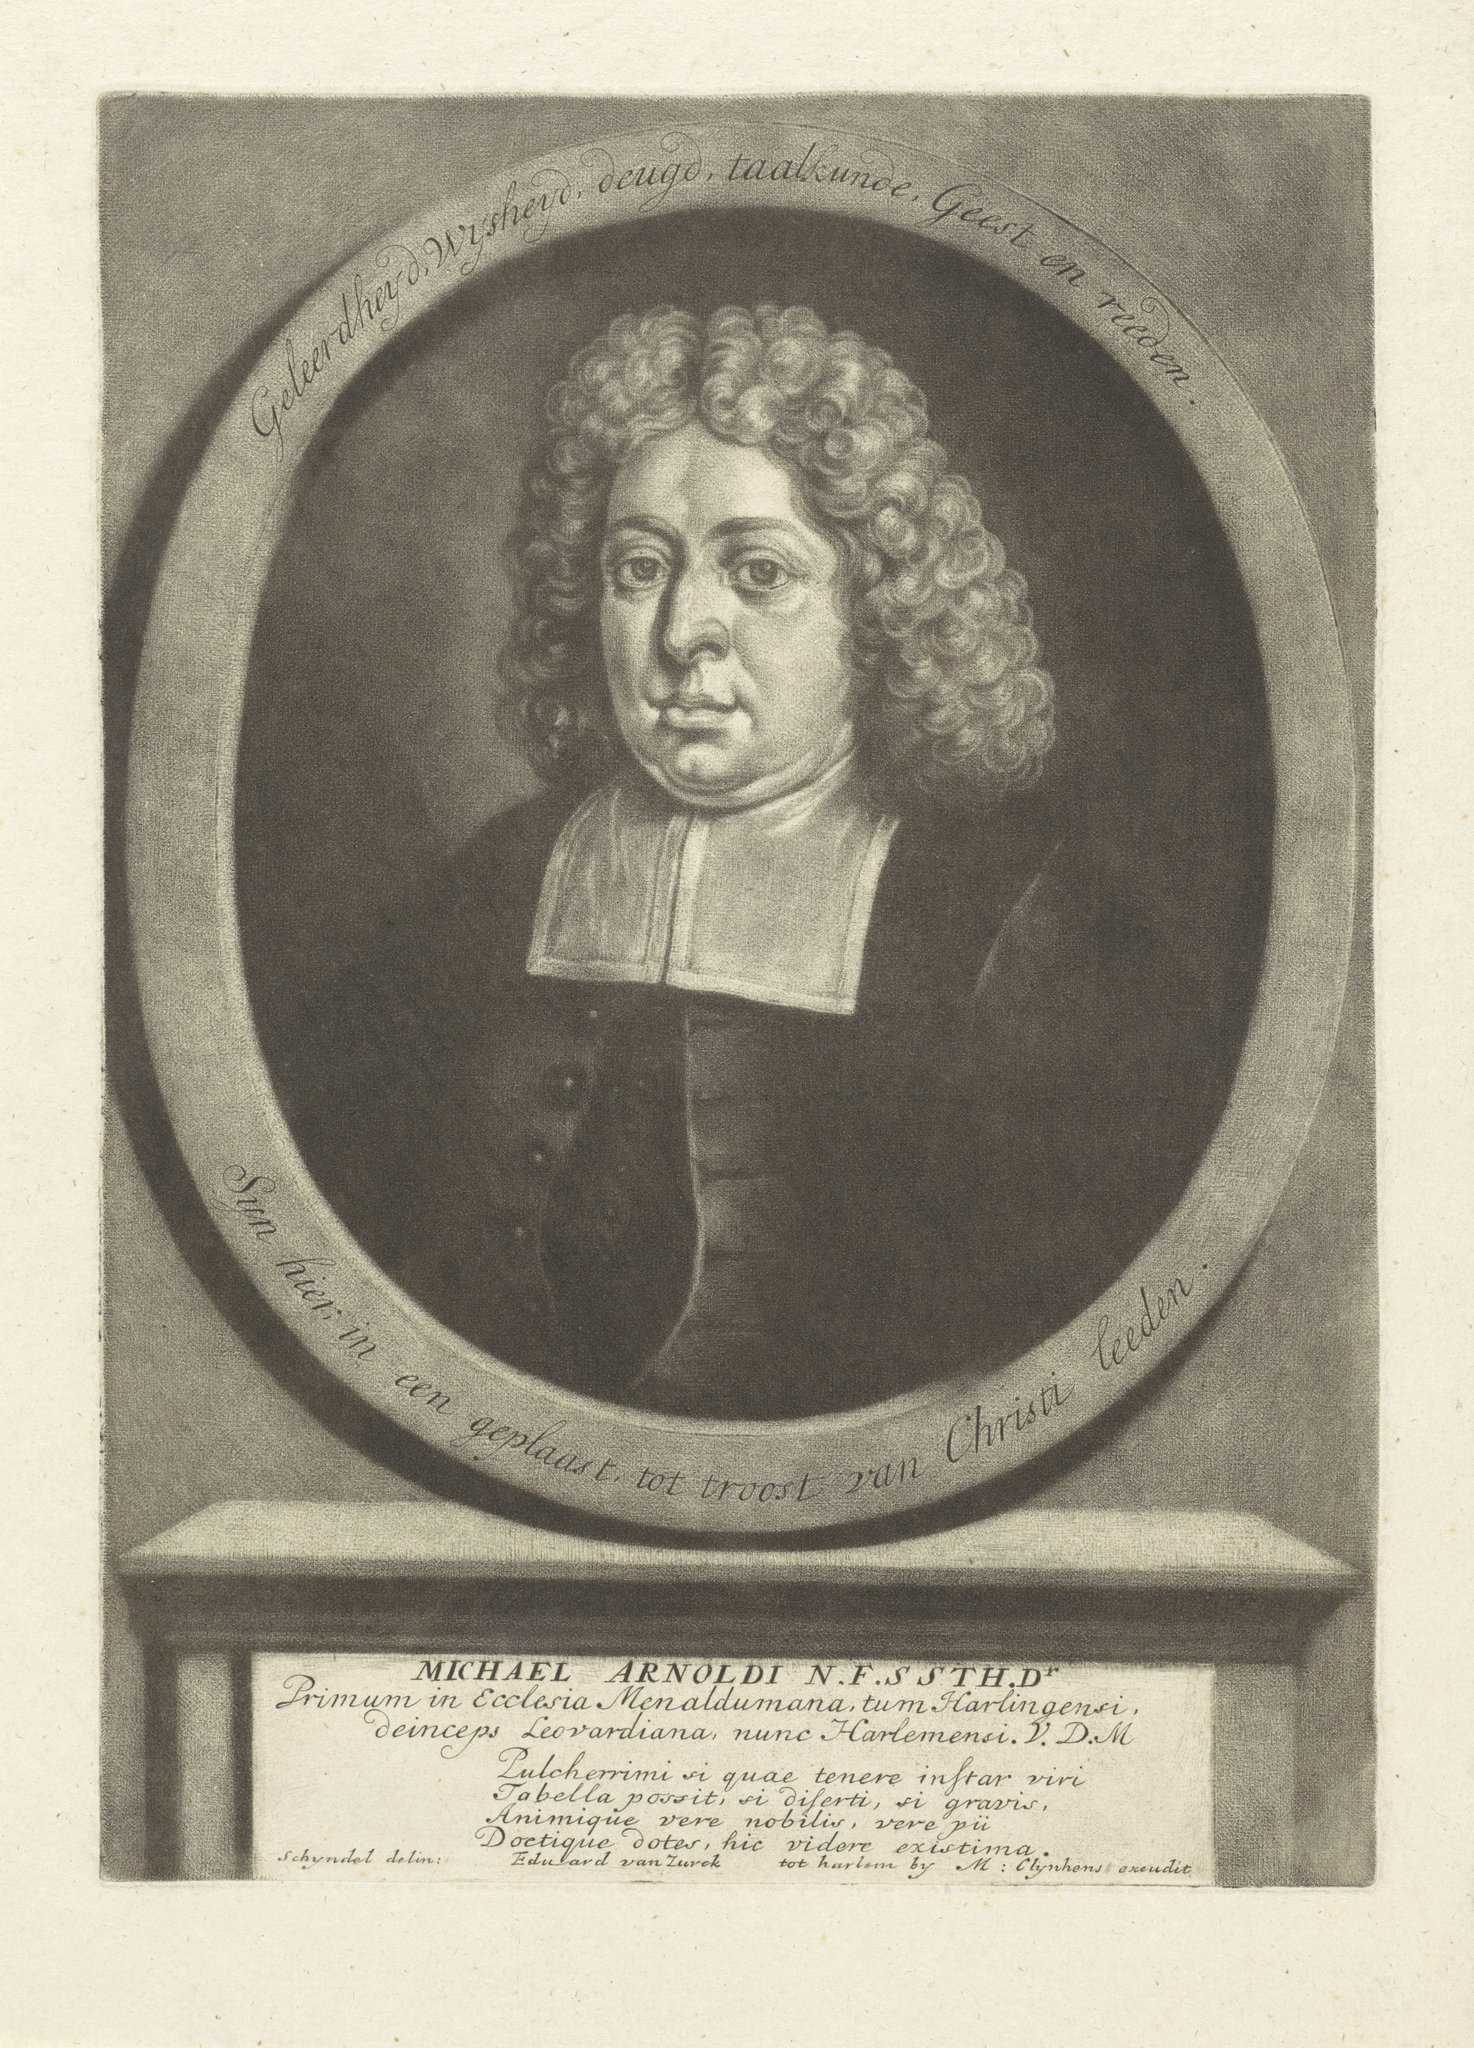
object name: print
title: Portret van de theoloog Michael Arnoldi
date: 1670-1724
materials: paper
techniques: engraving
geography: amsterdam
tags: haarlem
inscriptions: collector's mark: Lugt 2228